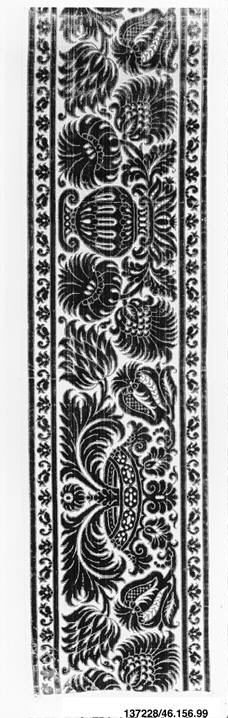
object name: border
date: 1551-1600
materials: silk